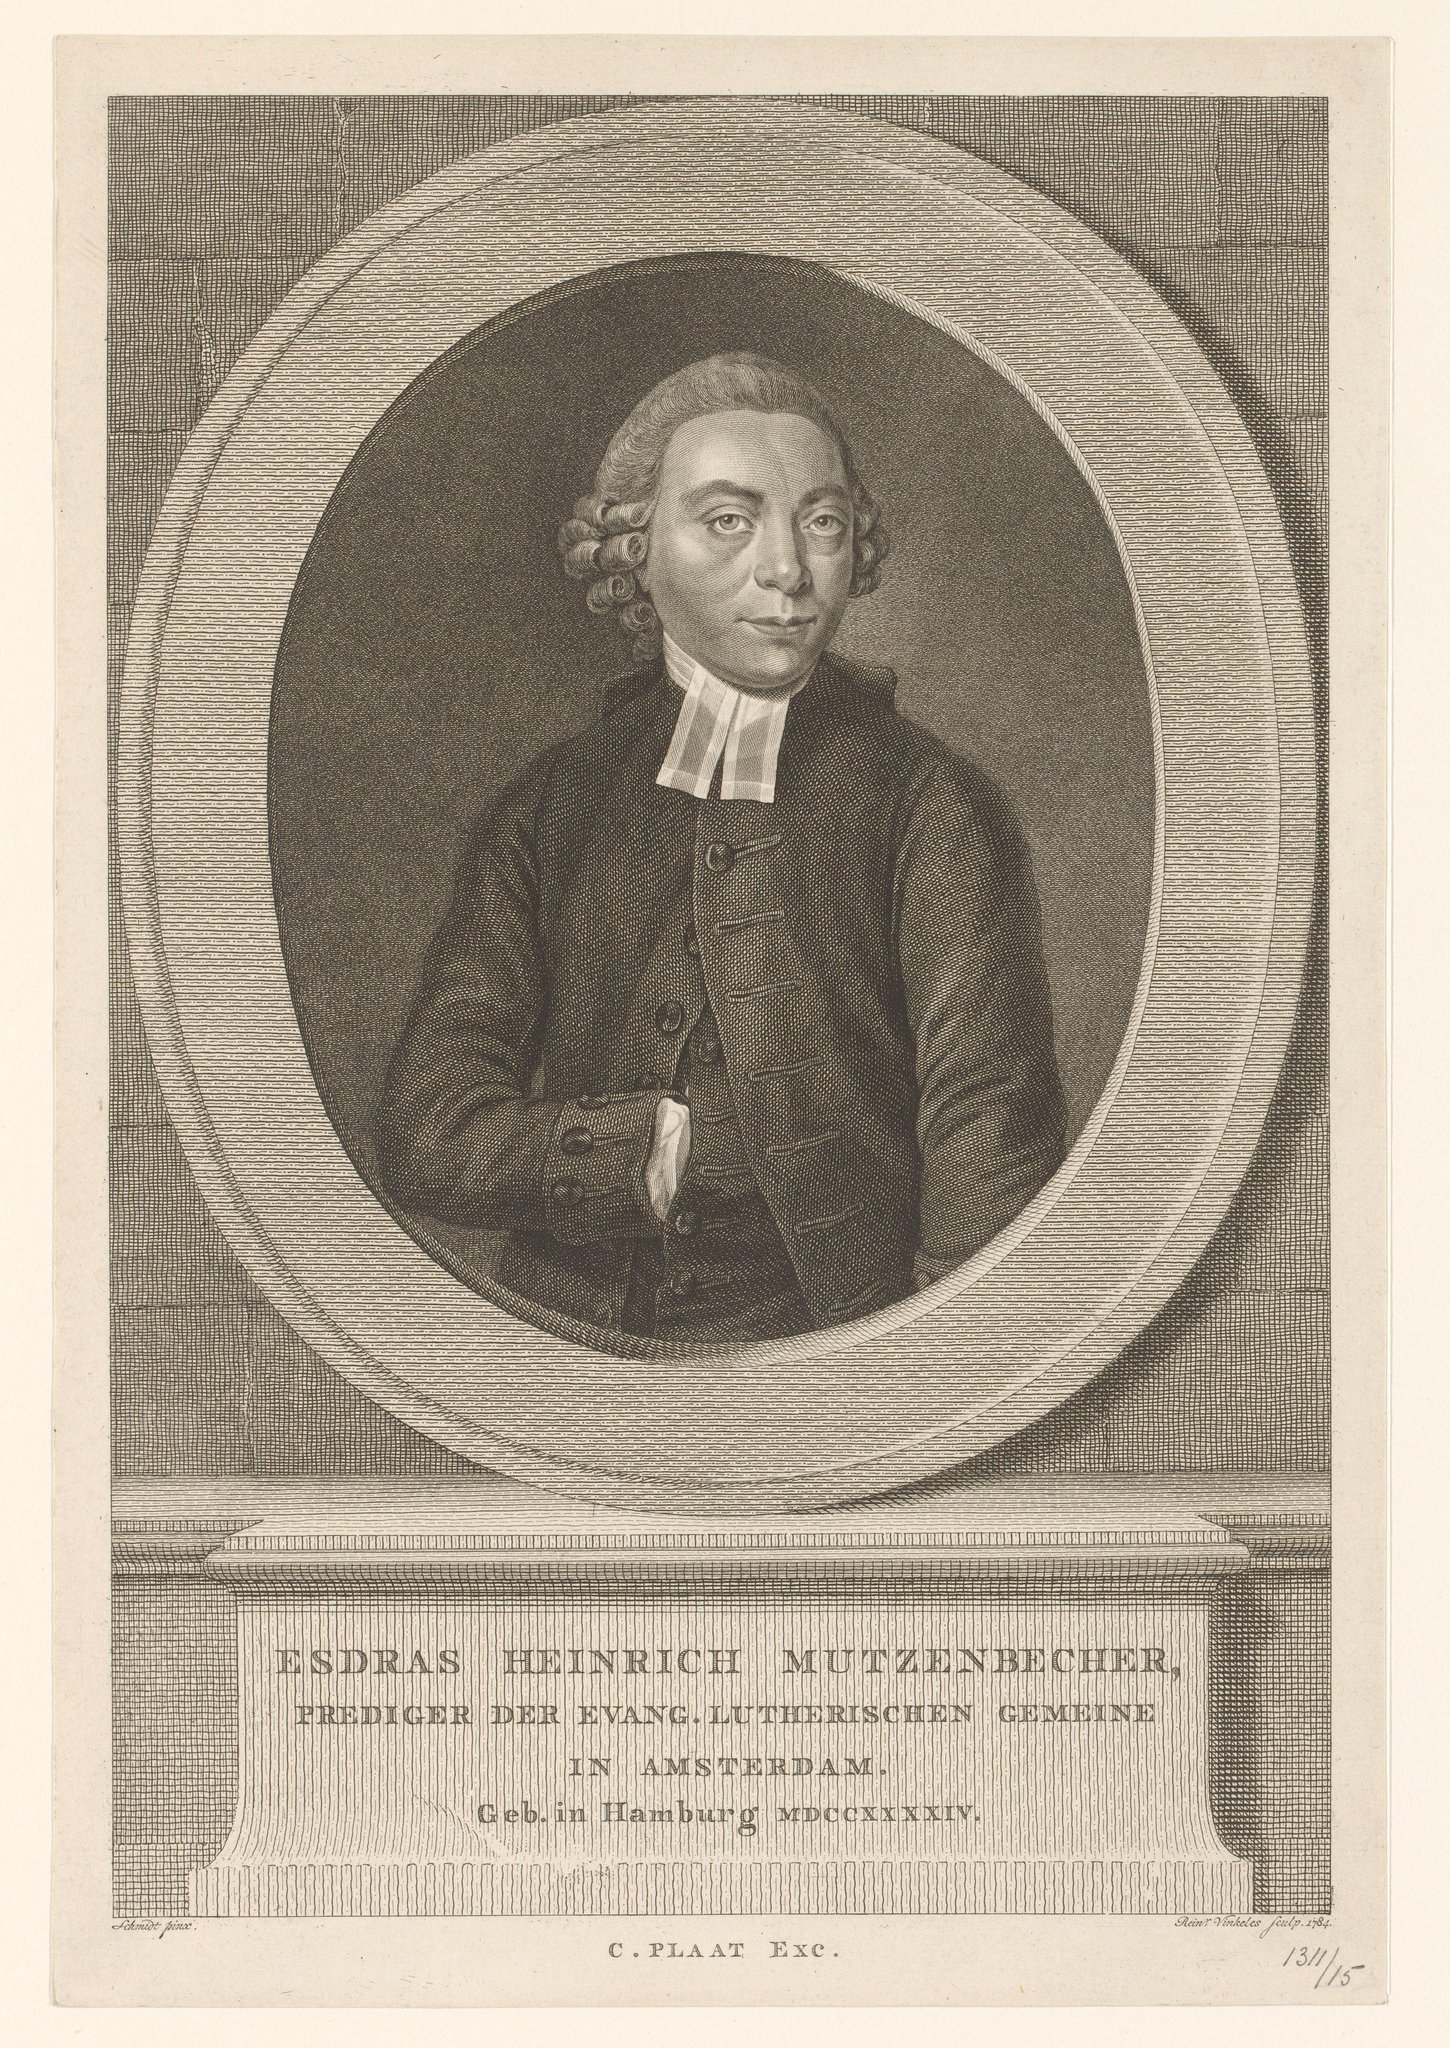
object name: print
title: Esdras Heinrich Mutzenbecher (...)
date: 1784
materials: paper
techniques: engraving, etching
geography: the hague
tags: esdras heinrich mützenbecher, historical persons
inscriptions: collector's mark: Lugt 240, number: ‘1311/15’, collector's mark: Lugt 789a